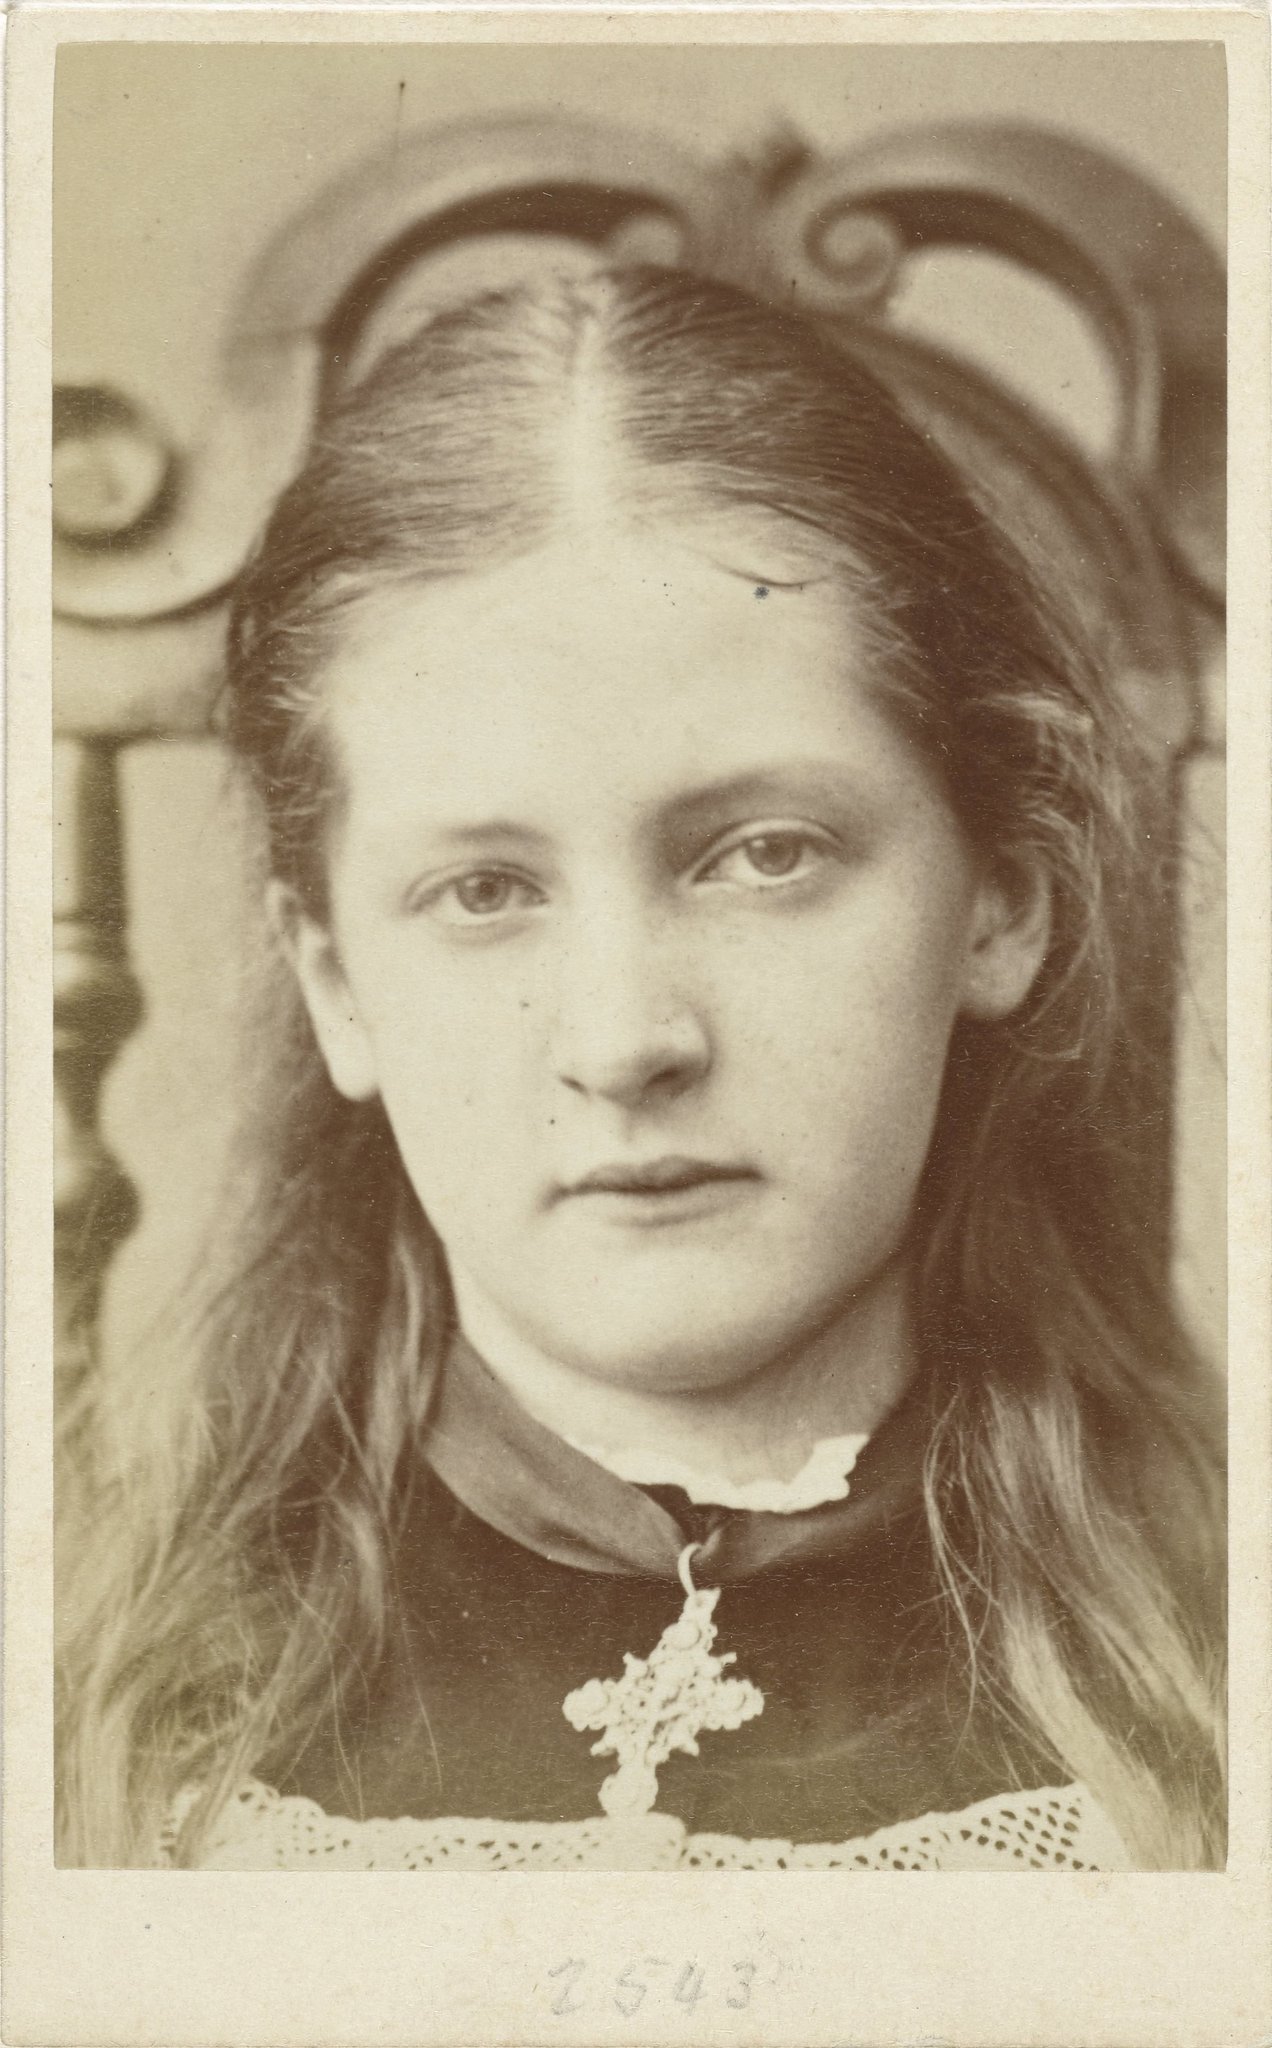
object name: photograph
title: Cartes-de-visite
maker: lewis carroll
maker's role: fotograaf, schrijver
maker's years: 1832-1898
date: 1878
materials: cardboard, paper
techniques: albumen print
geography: oxford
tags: london, great britain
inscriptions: negative number: ‘2543’, negative number: ‘2543’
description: Cartomanie was a collecting craze. From 1855 hundreds of thousands of these portraits were annually sold worldwide. People had photographs taken of their loved ones, including their pets, and kept them in an album. Portraits of kings, writers, artists, actors, and statesmen were also collected. Photography was no longer the preserve of the wealthy; farmers and maidservants now also stood before the camera.